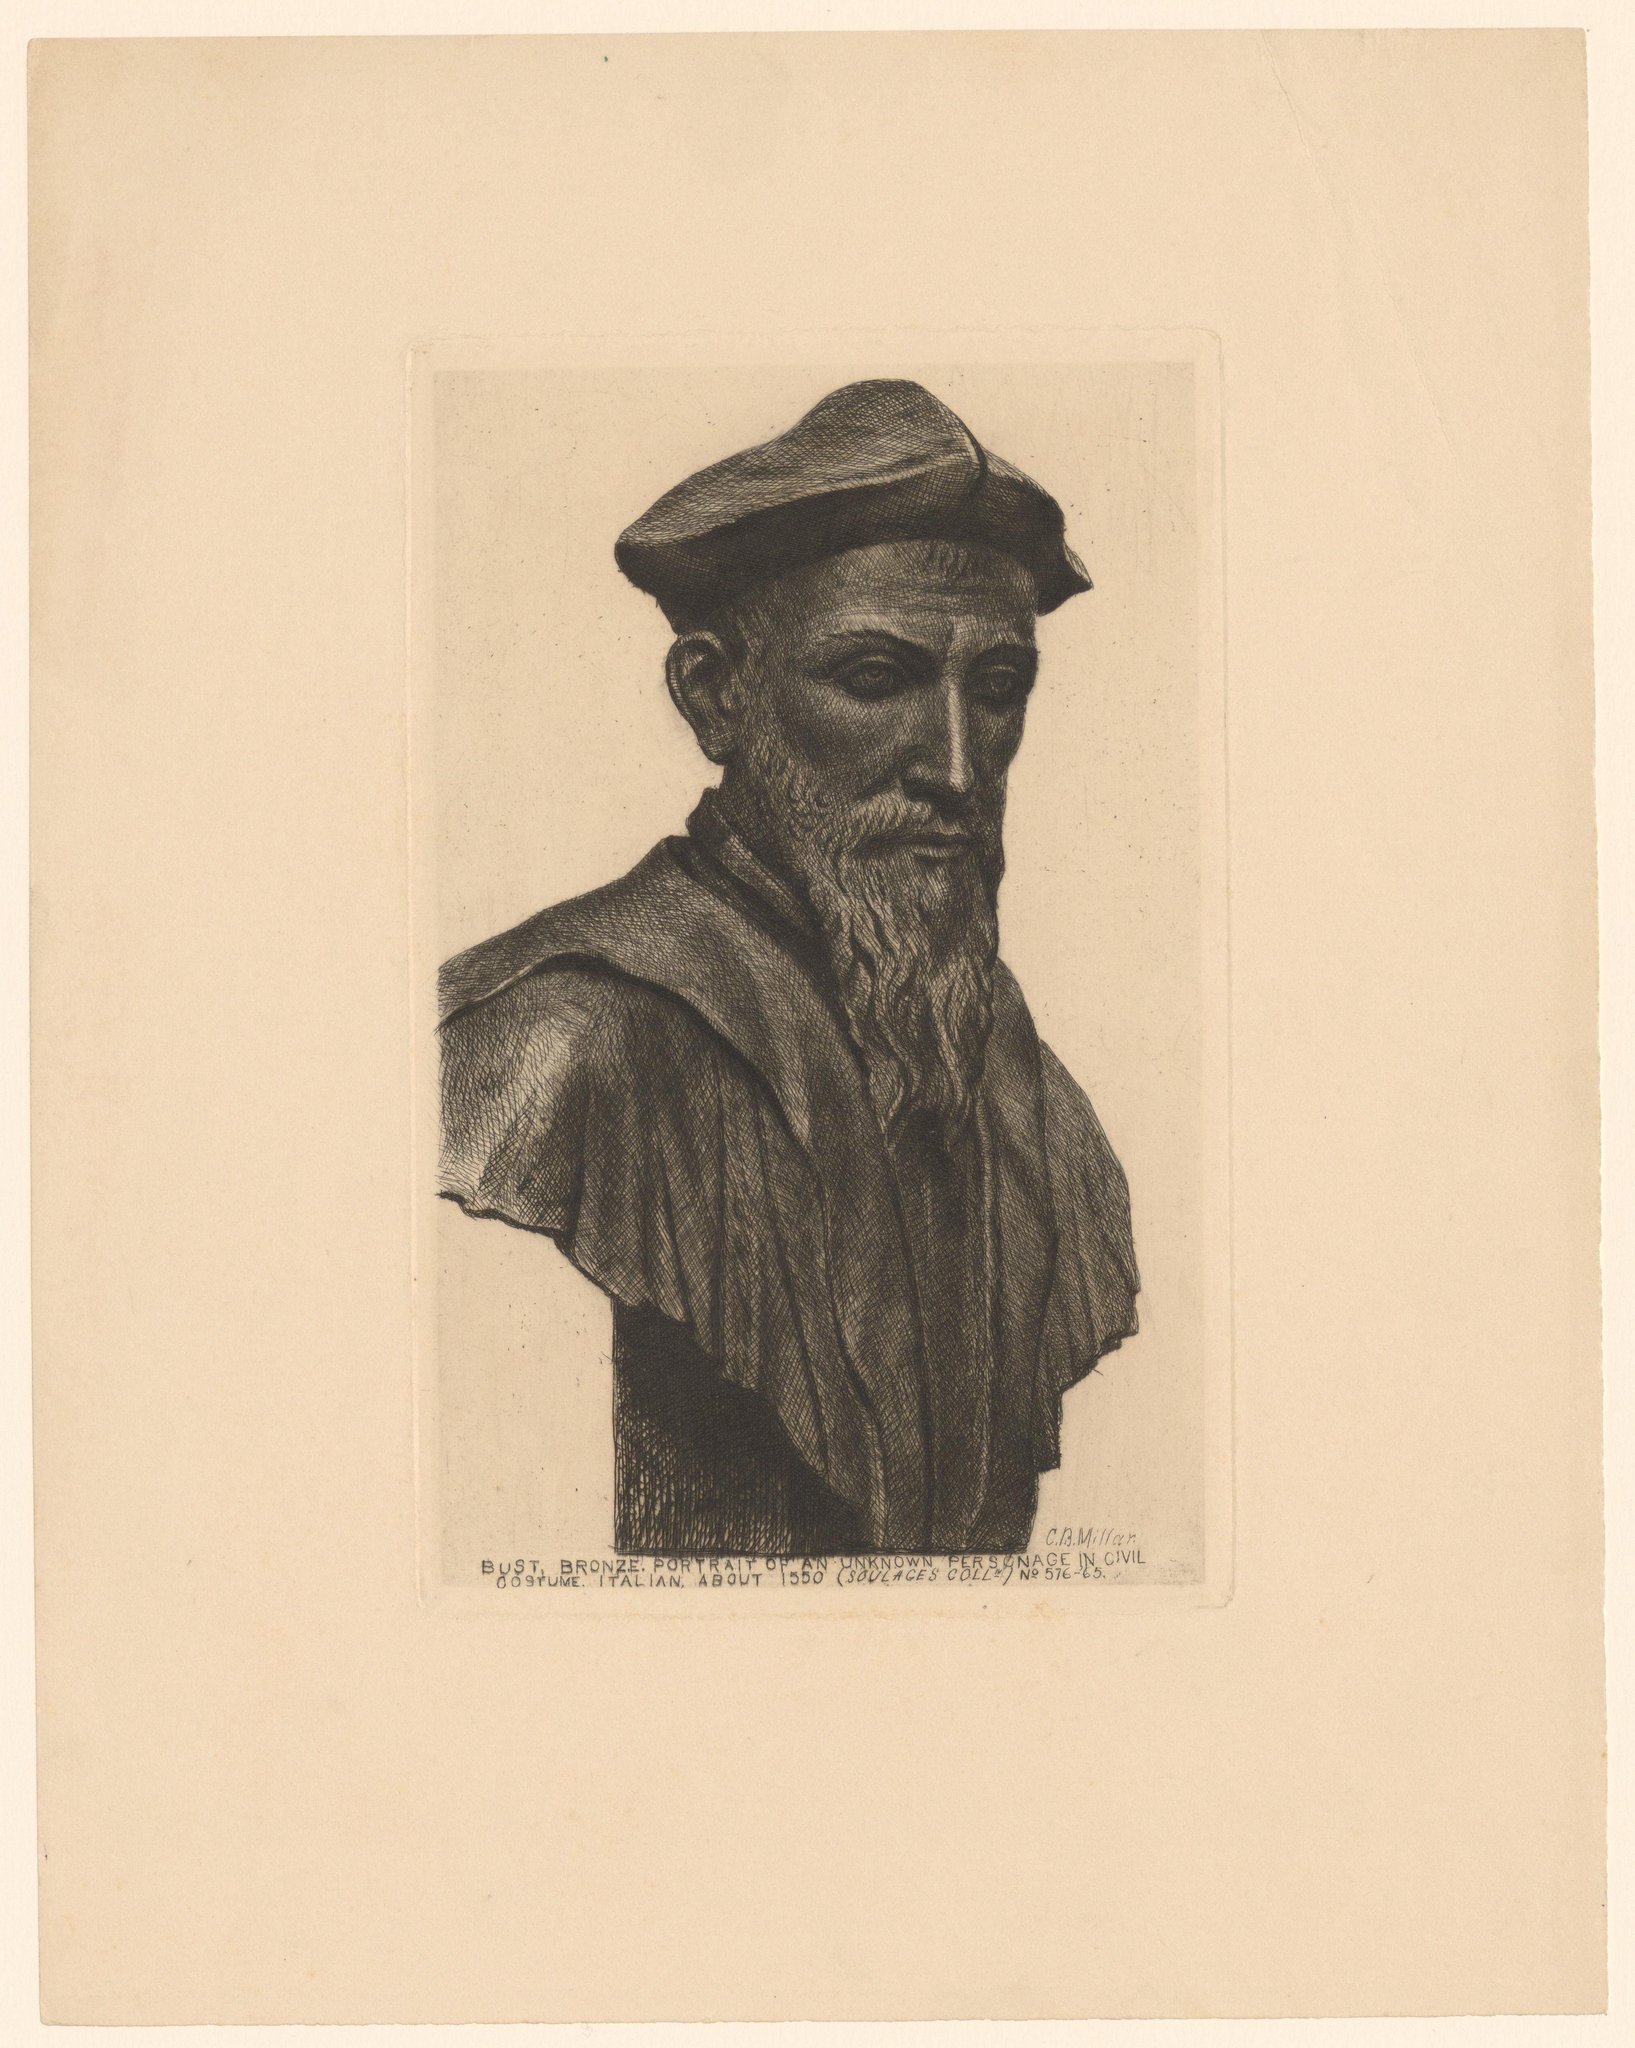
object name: print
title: Bust, bronze. Portrait of an unknown personage in civil costume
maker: c.b. millar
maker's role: print maker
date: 1876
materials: paper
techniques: drypoint, etching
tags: sculpture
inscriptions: collector's mark: Lugt 2228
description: Prent is deel van een groep prenten gemaakt door leerlingen van Alphonse Legros, naar kunstwerken in het Victoria & Albert Museum.